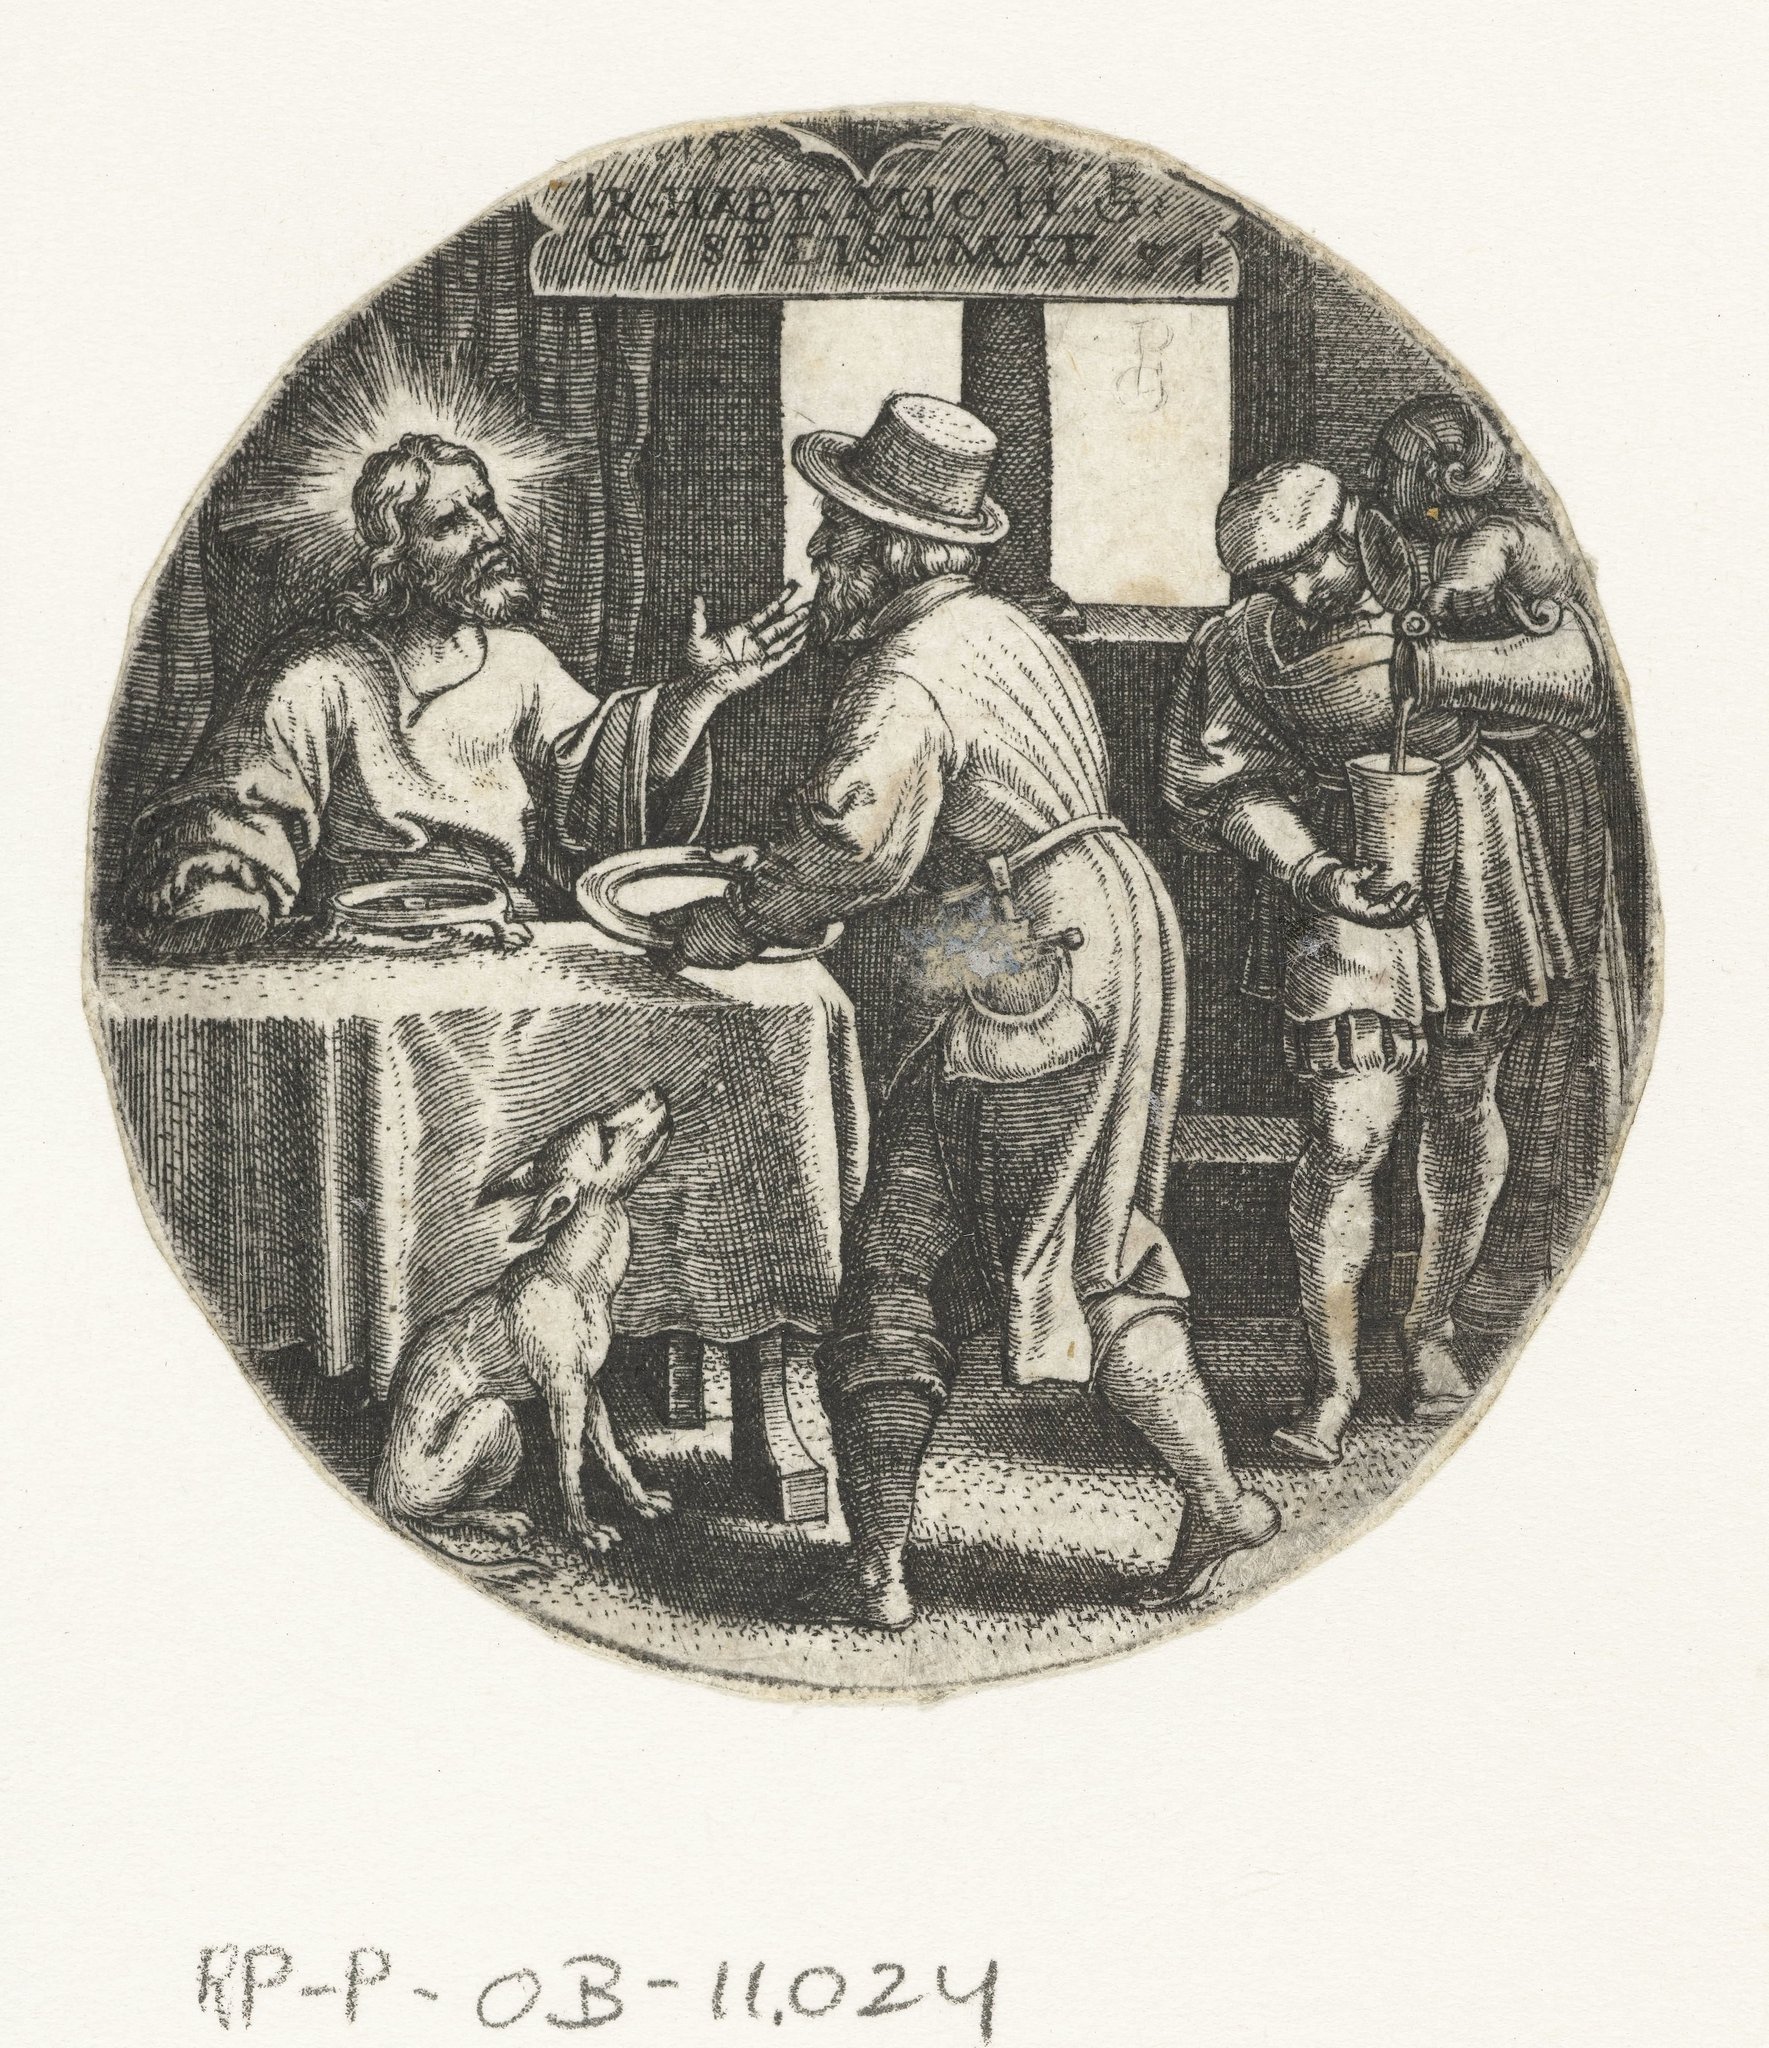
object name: print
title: Christus krijgt eten als hij hongerig is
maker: georg pencz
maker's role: draughtsman, painter, print maker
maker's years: 1500-1550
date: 1534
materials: paper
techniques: engraving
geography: germany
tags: feeding the hungry, 'esuriens cibatur' ~ one of the (seven) acts of mercy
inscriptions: collector's mark: Lugt 240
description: Christus krijgt eten als hij hongerig is (Matteüs 25:34)